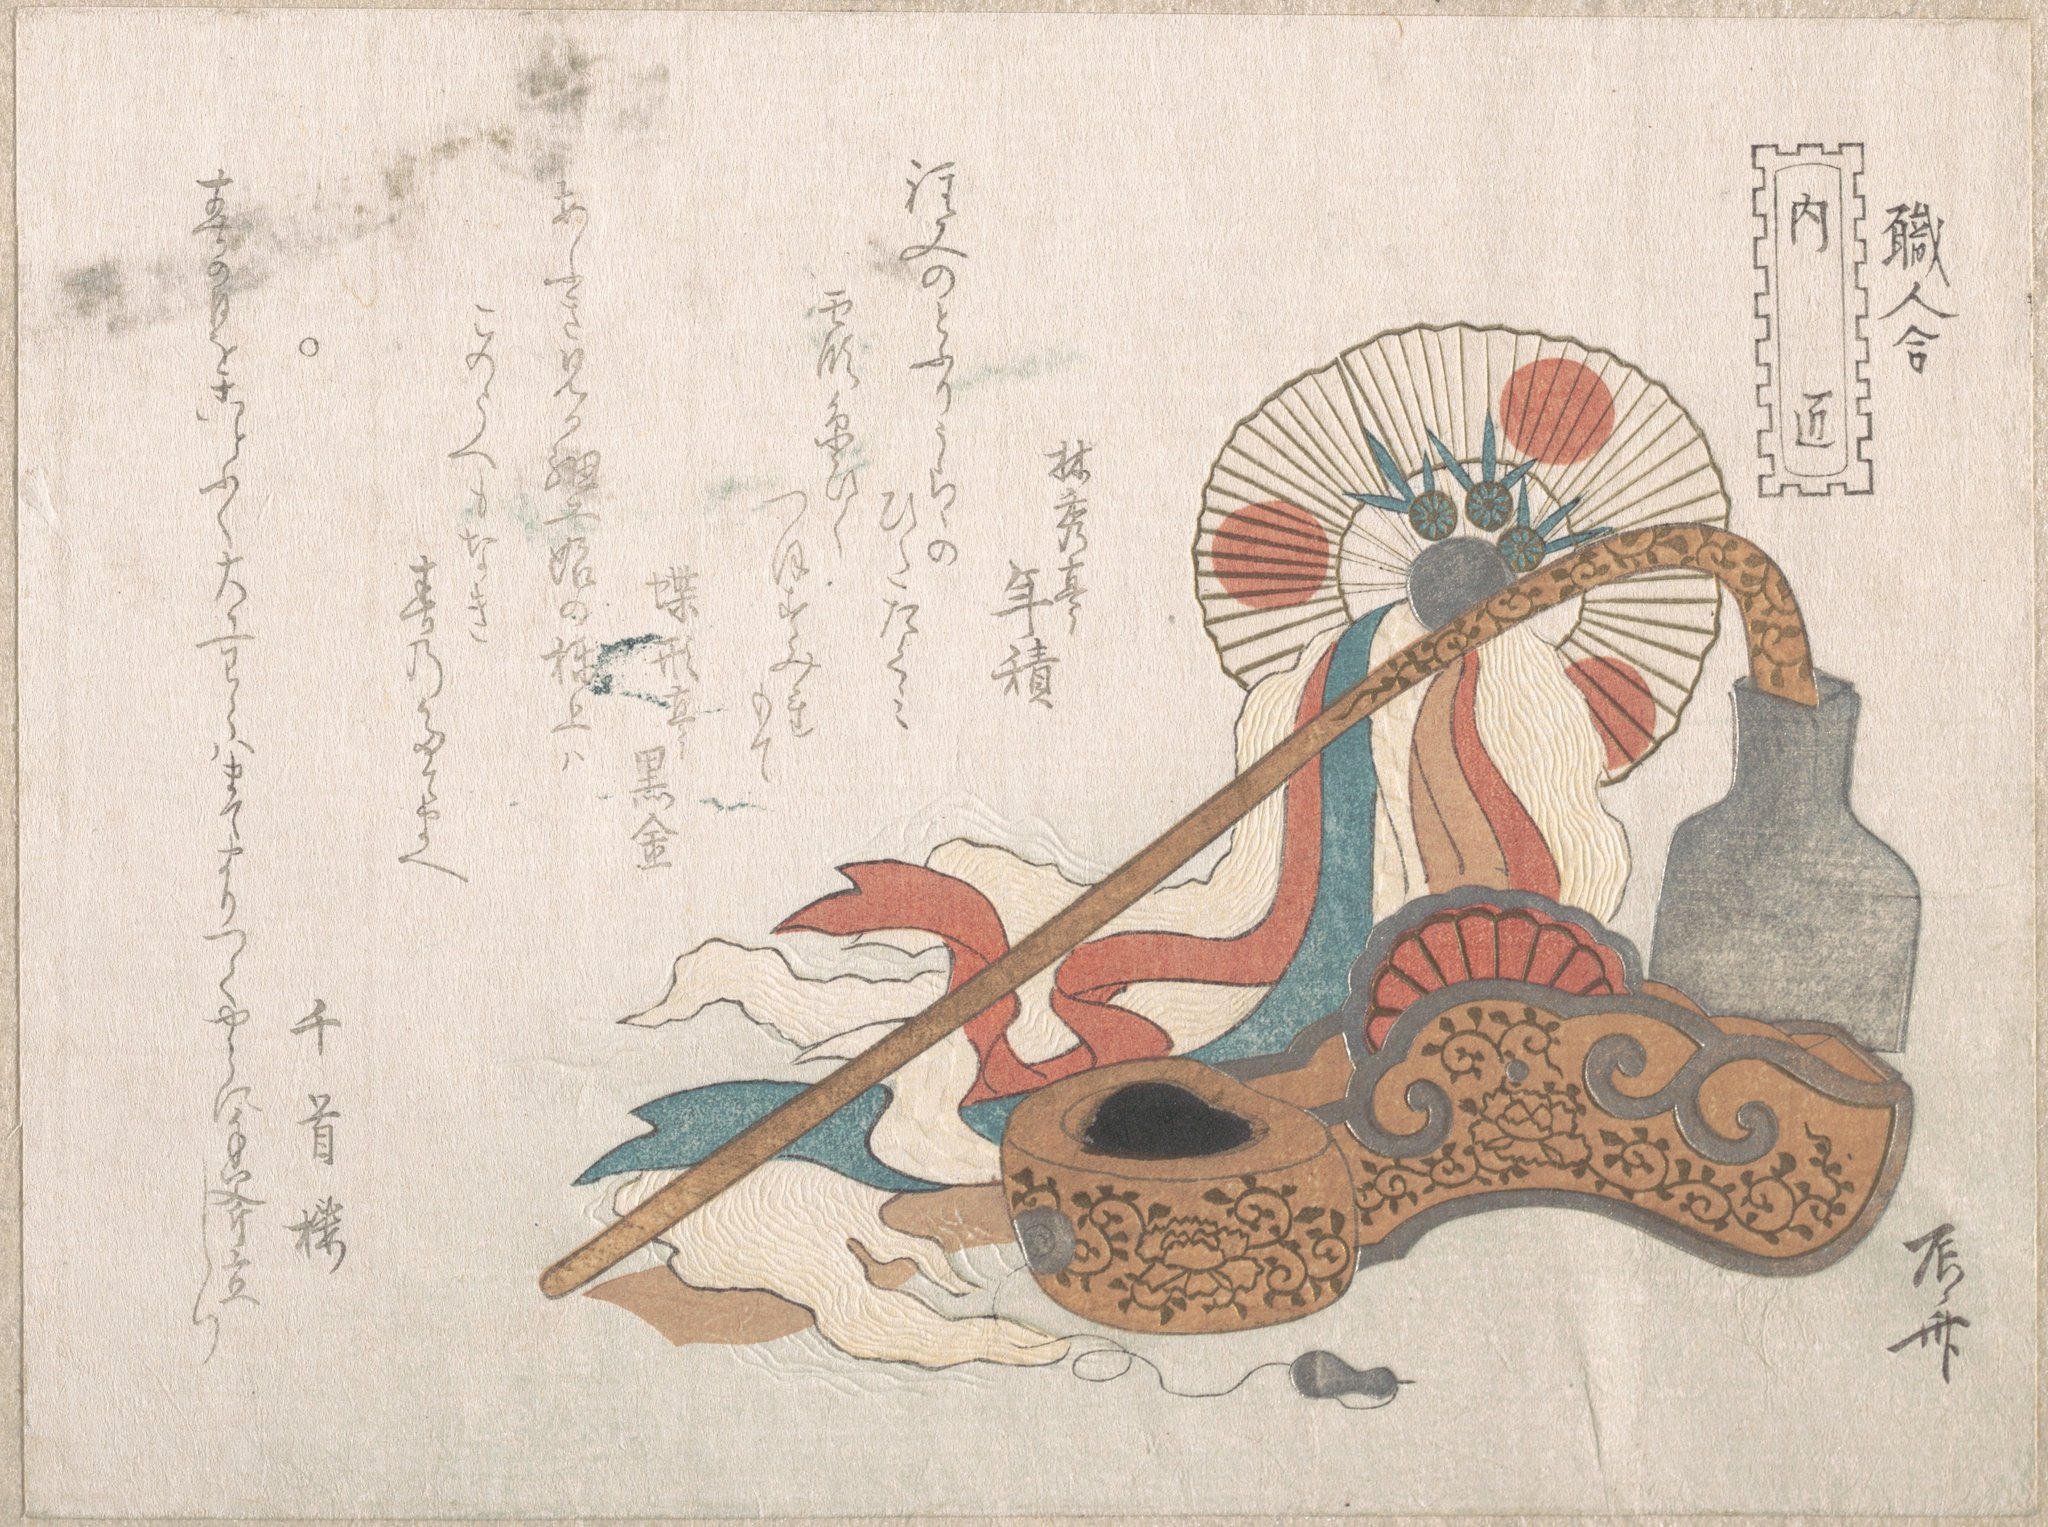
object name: woodblock print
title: Tools for the Carpenter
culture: japanese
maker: ryūryūkyo shinsai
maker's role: artist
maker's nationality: japanese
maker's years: 1799-1823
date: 1801-1900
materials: ink, paper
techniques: surimono, woodblock print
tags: tools